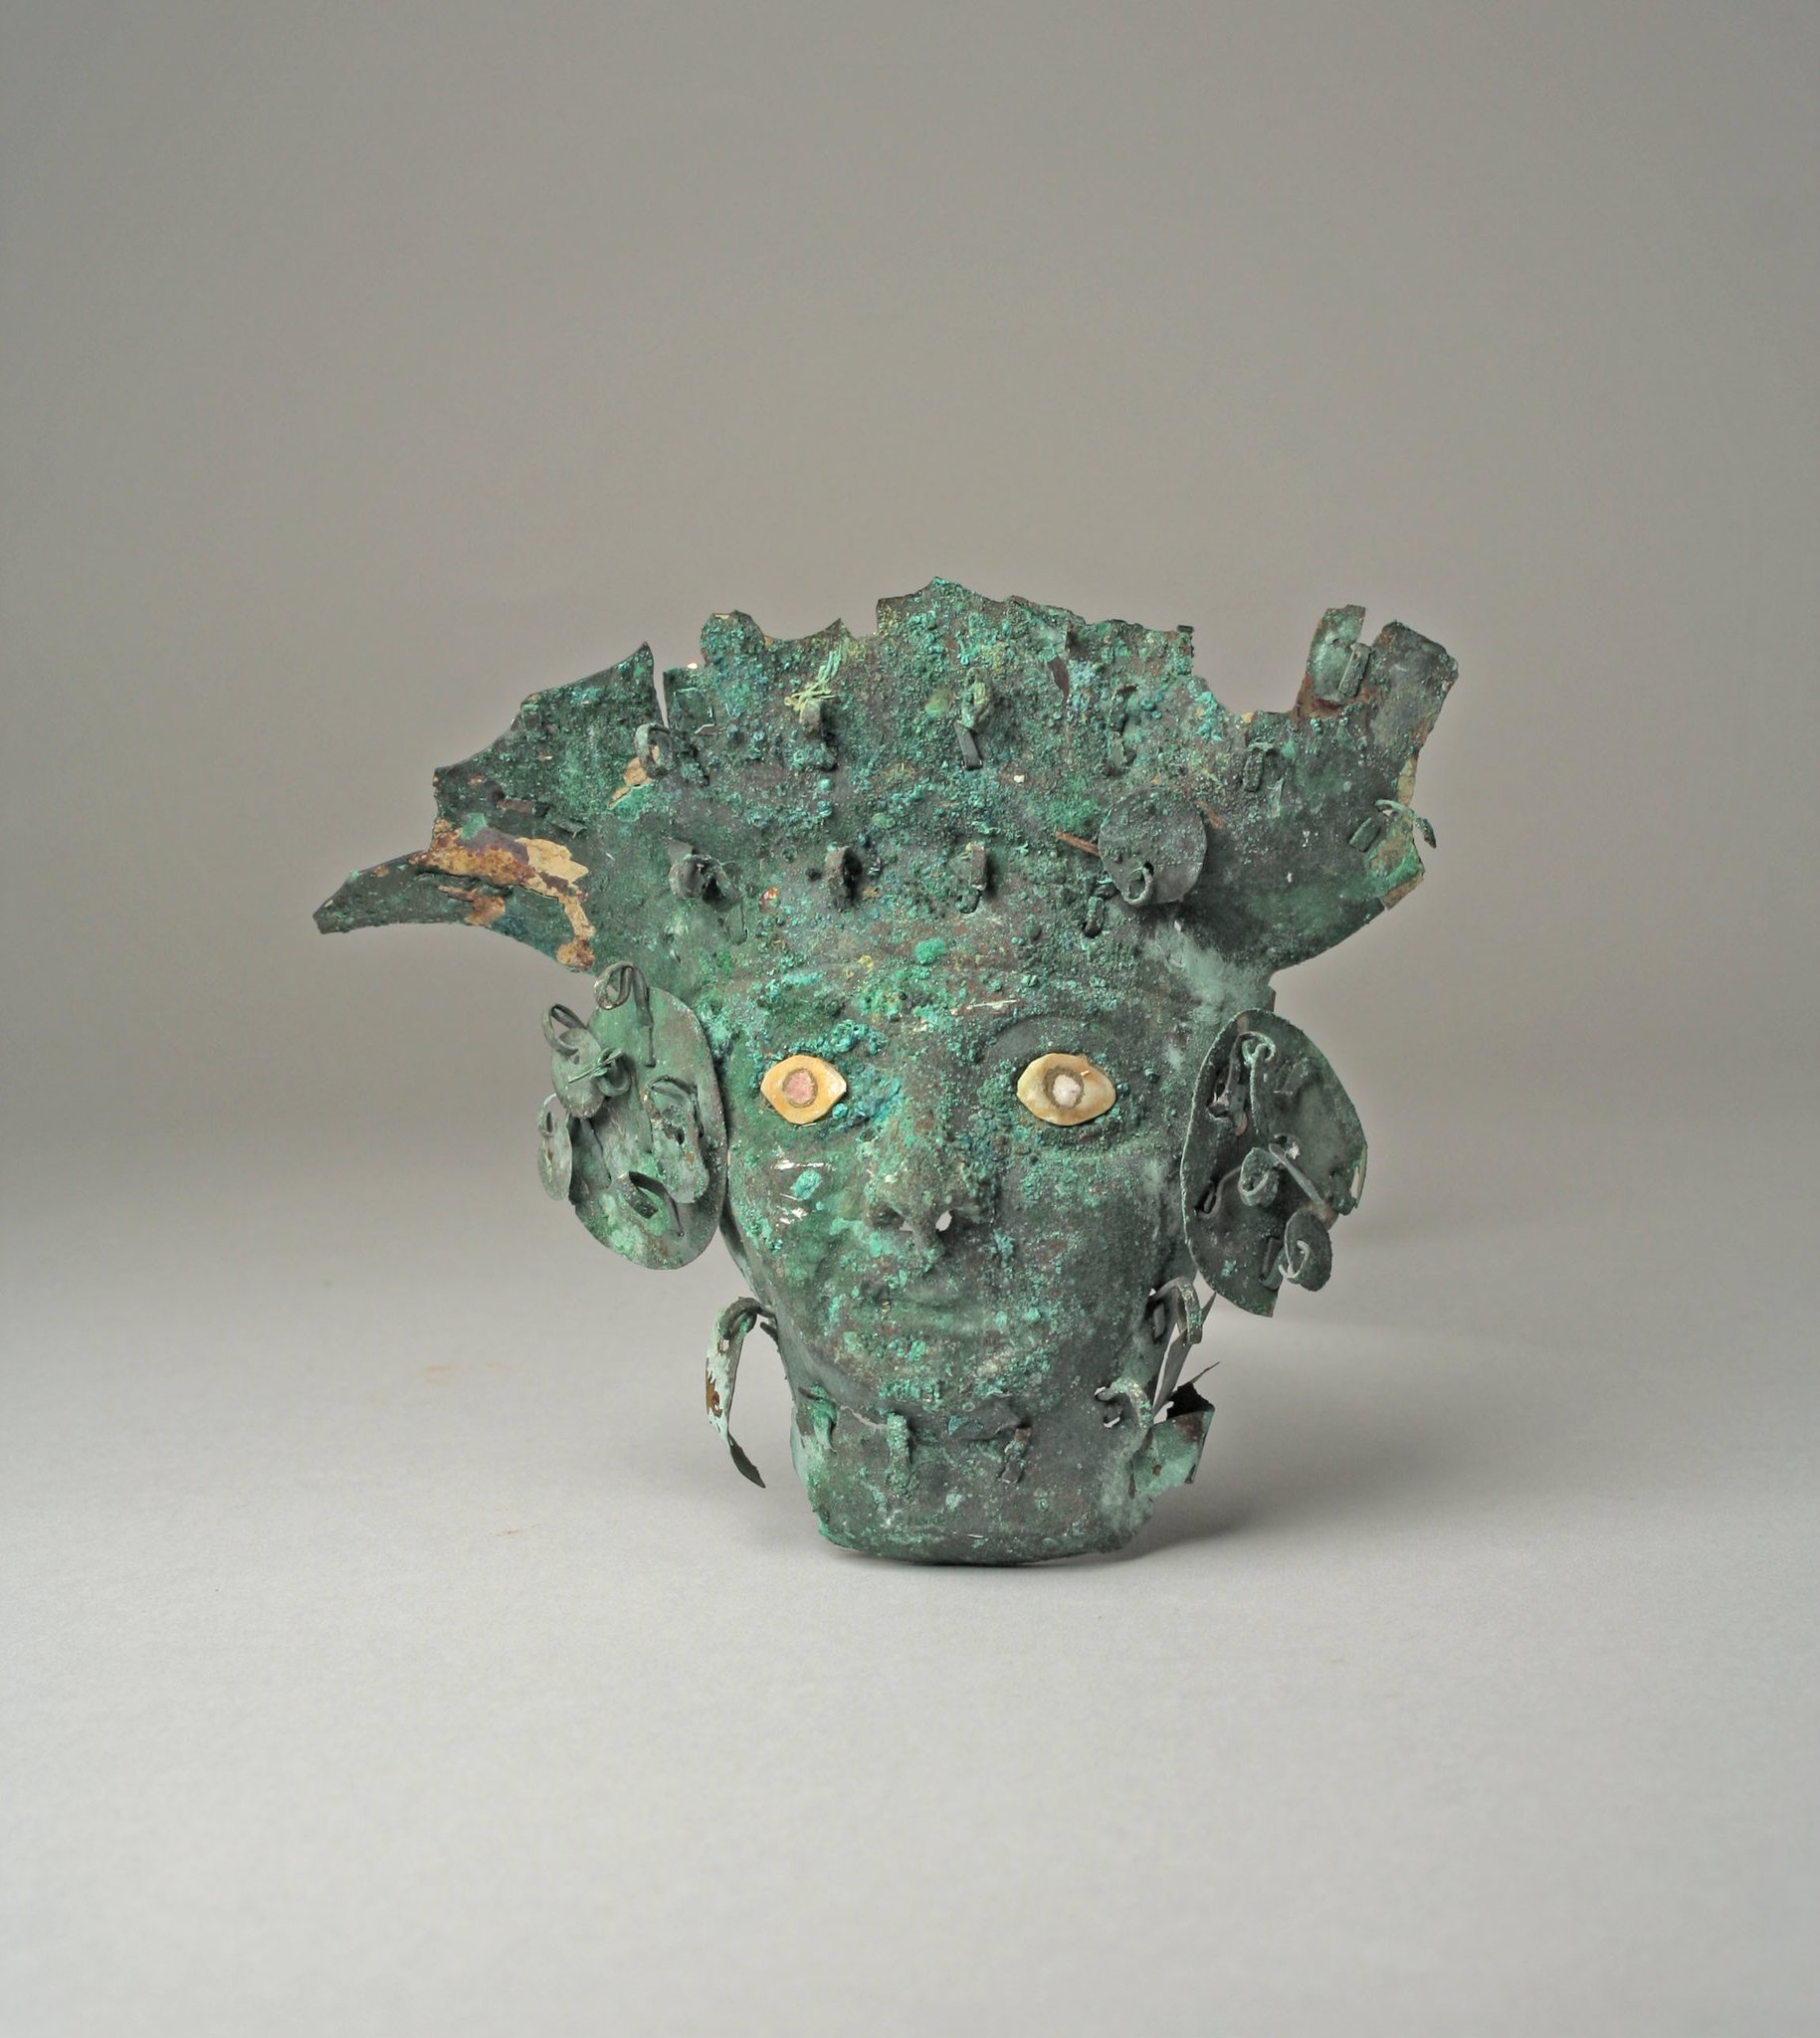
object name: ornament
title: Face Mask Ornament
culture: moche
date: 501-700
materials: gilt copper, shell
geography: peru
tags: faces